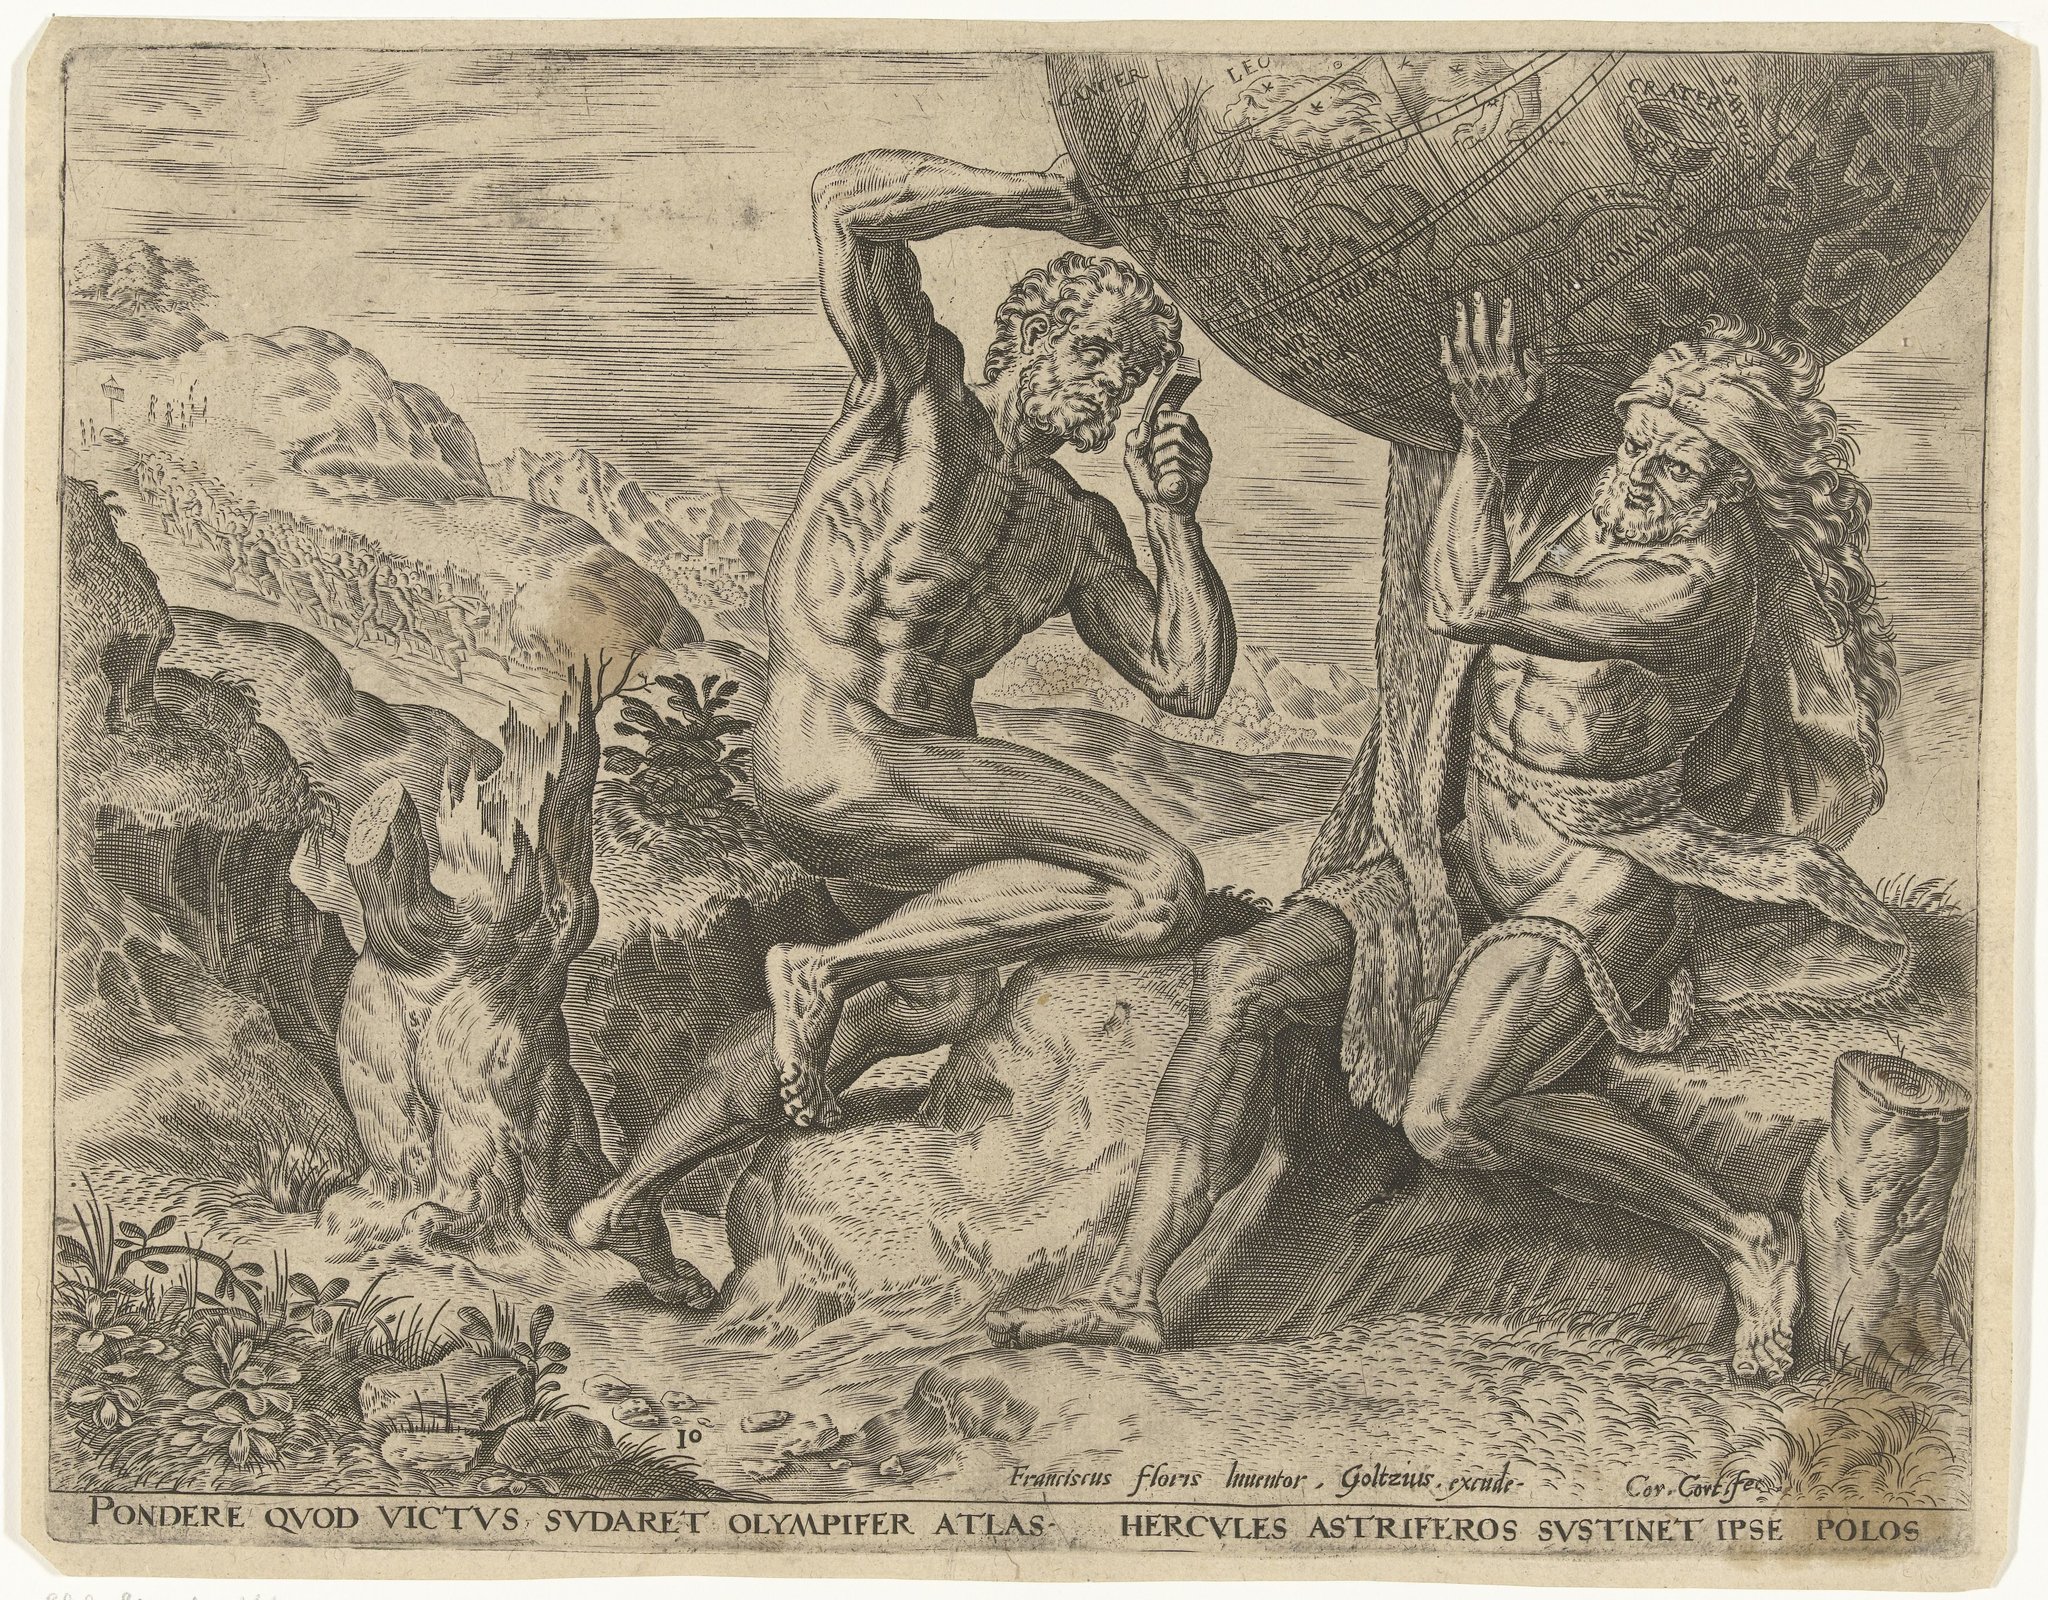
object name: print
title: Hercules torst de wereldbol voor Atlas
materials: paper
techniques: engraving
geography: antwerp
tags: hercules asks atlas to fetch the apples of the hesperides, hercules carries the heavens on his shoulders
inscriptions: caption: ‘Pondere quod victus...sustinet ipse polos’, collector's mark: Lugt 2228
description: Hercules neemt de wereldbol van Atlas over en draagt hem op zijn schouder. Zo kan Atlas voor Hercules de gouden appelen van de Hesperiden stelen.